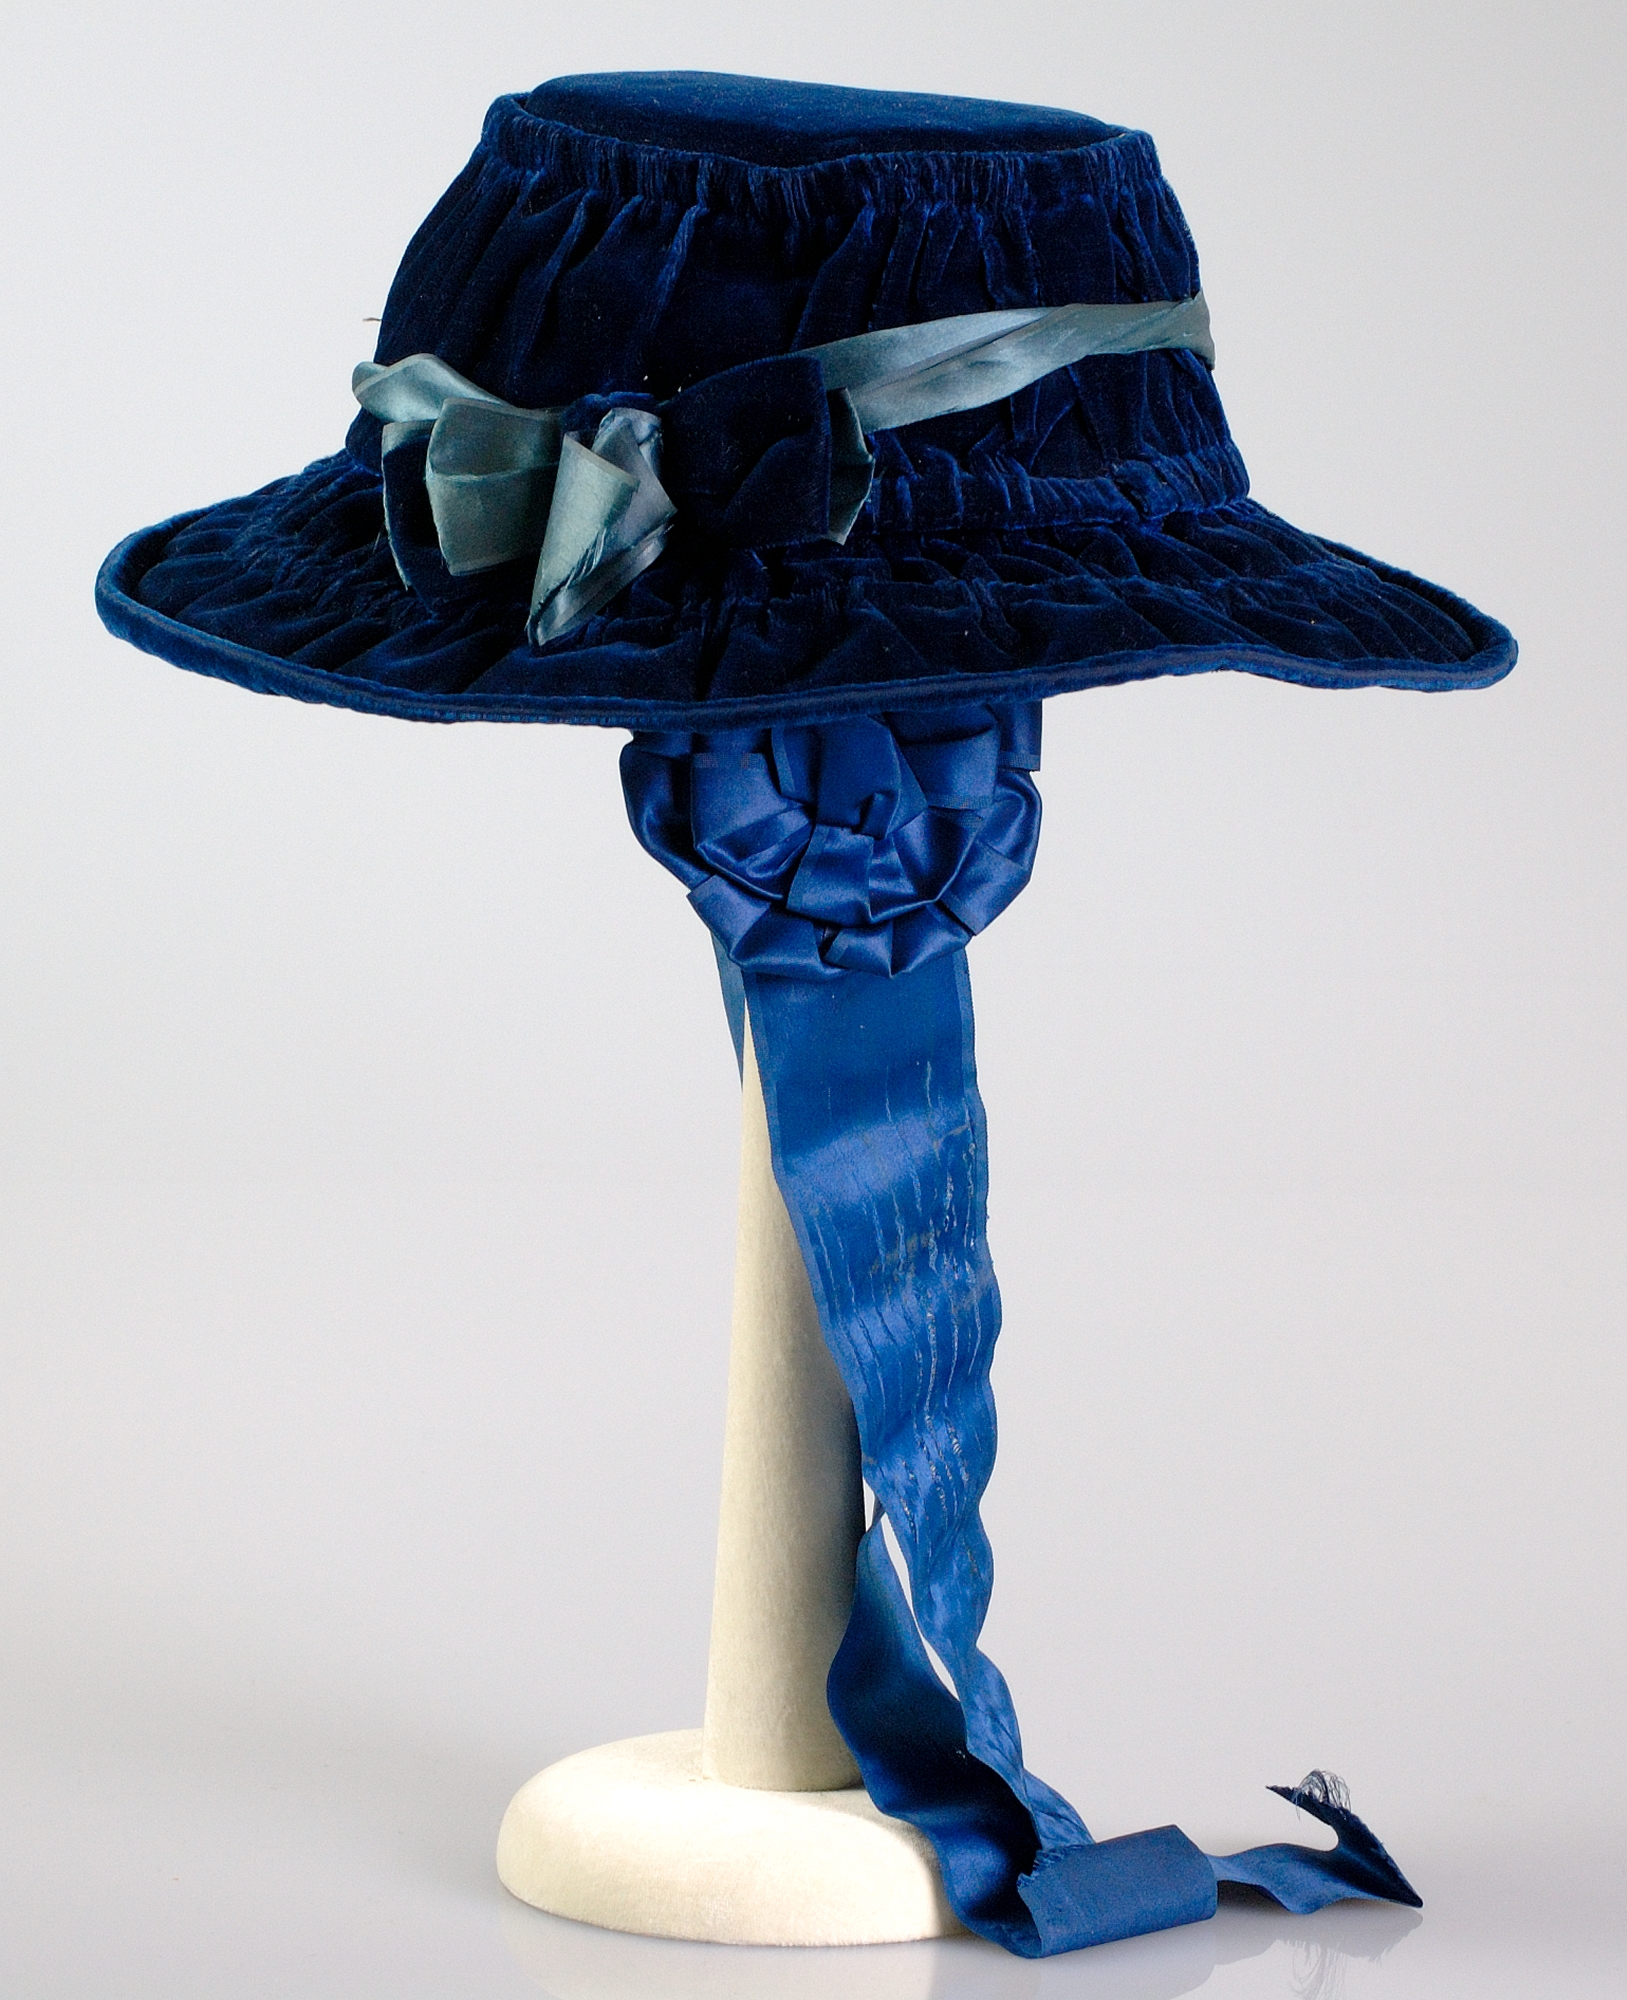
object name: hat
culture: american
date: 1855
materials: silk